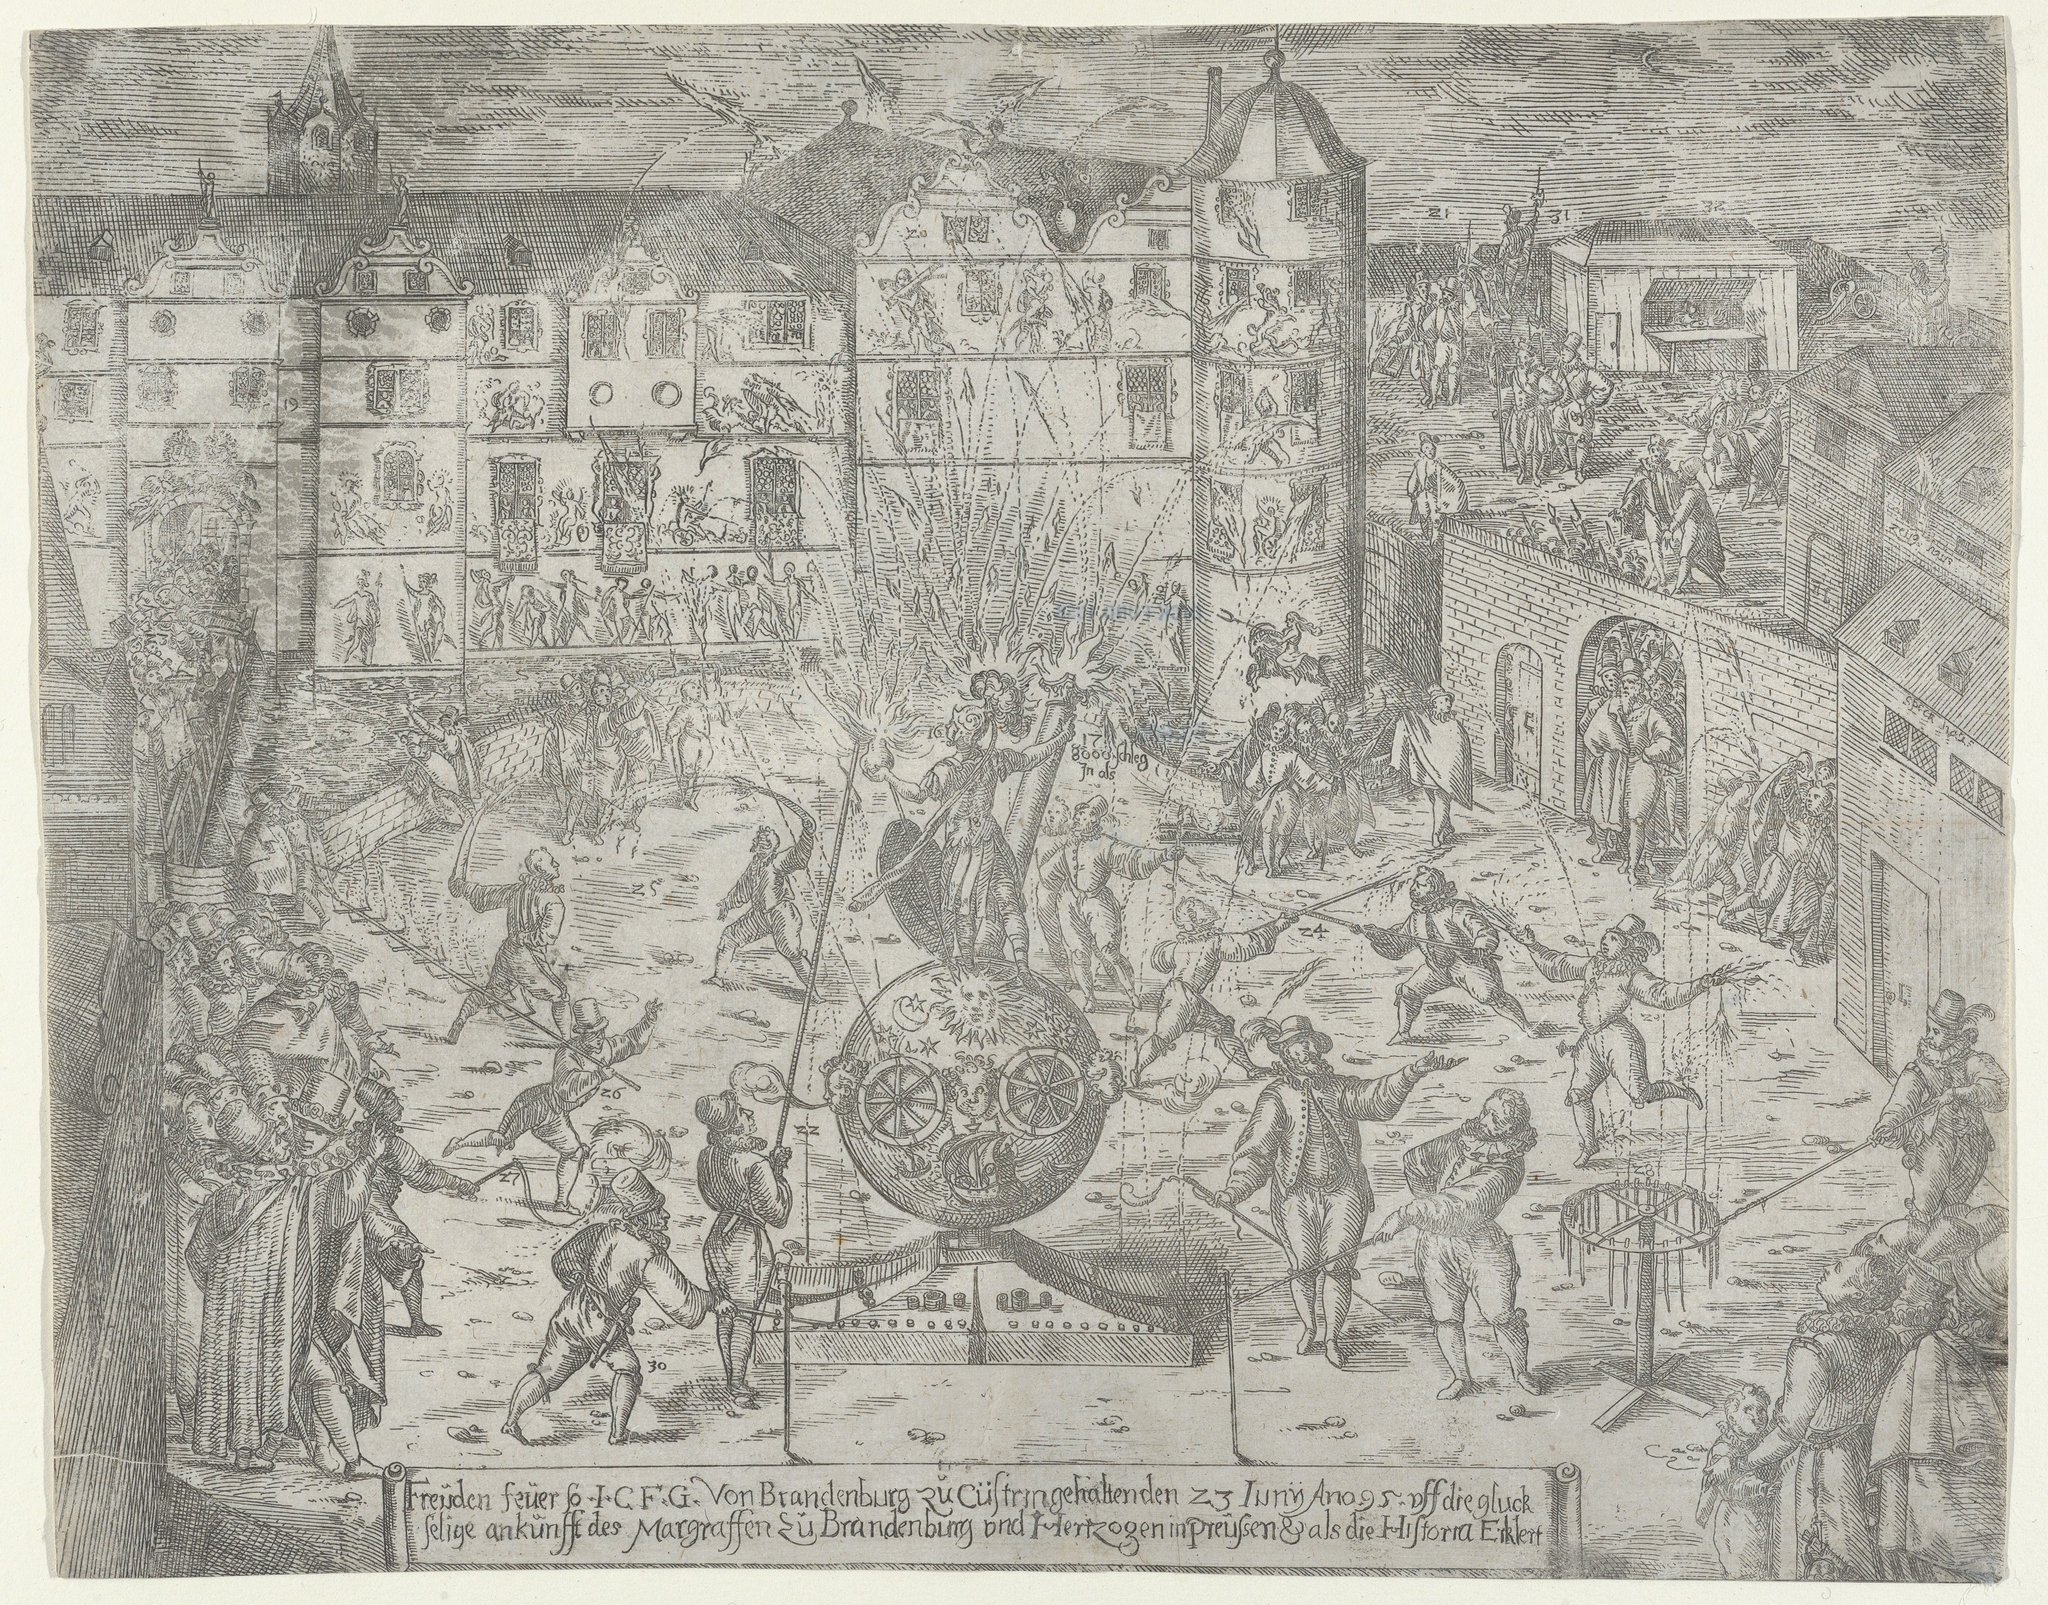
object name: print, fete, ornament architecture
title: Fireworks on June 23, 1595, for the entry to Küstrin of the Margrave of Brandenburg and Duchess of Prussia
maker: georg keller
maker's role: artist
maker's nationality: german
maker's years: 1568-1634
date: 1595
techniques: etching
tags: buildings,men,fireworks